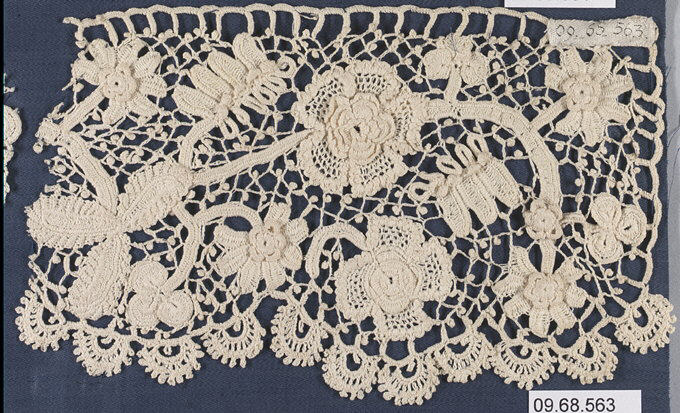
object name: specimen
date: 1801-1900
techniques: crochet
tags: flowers